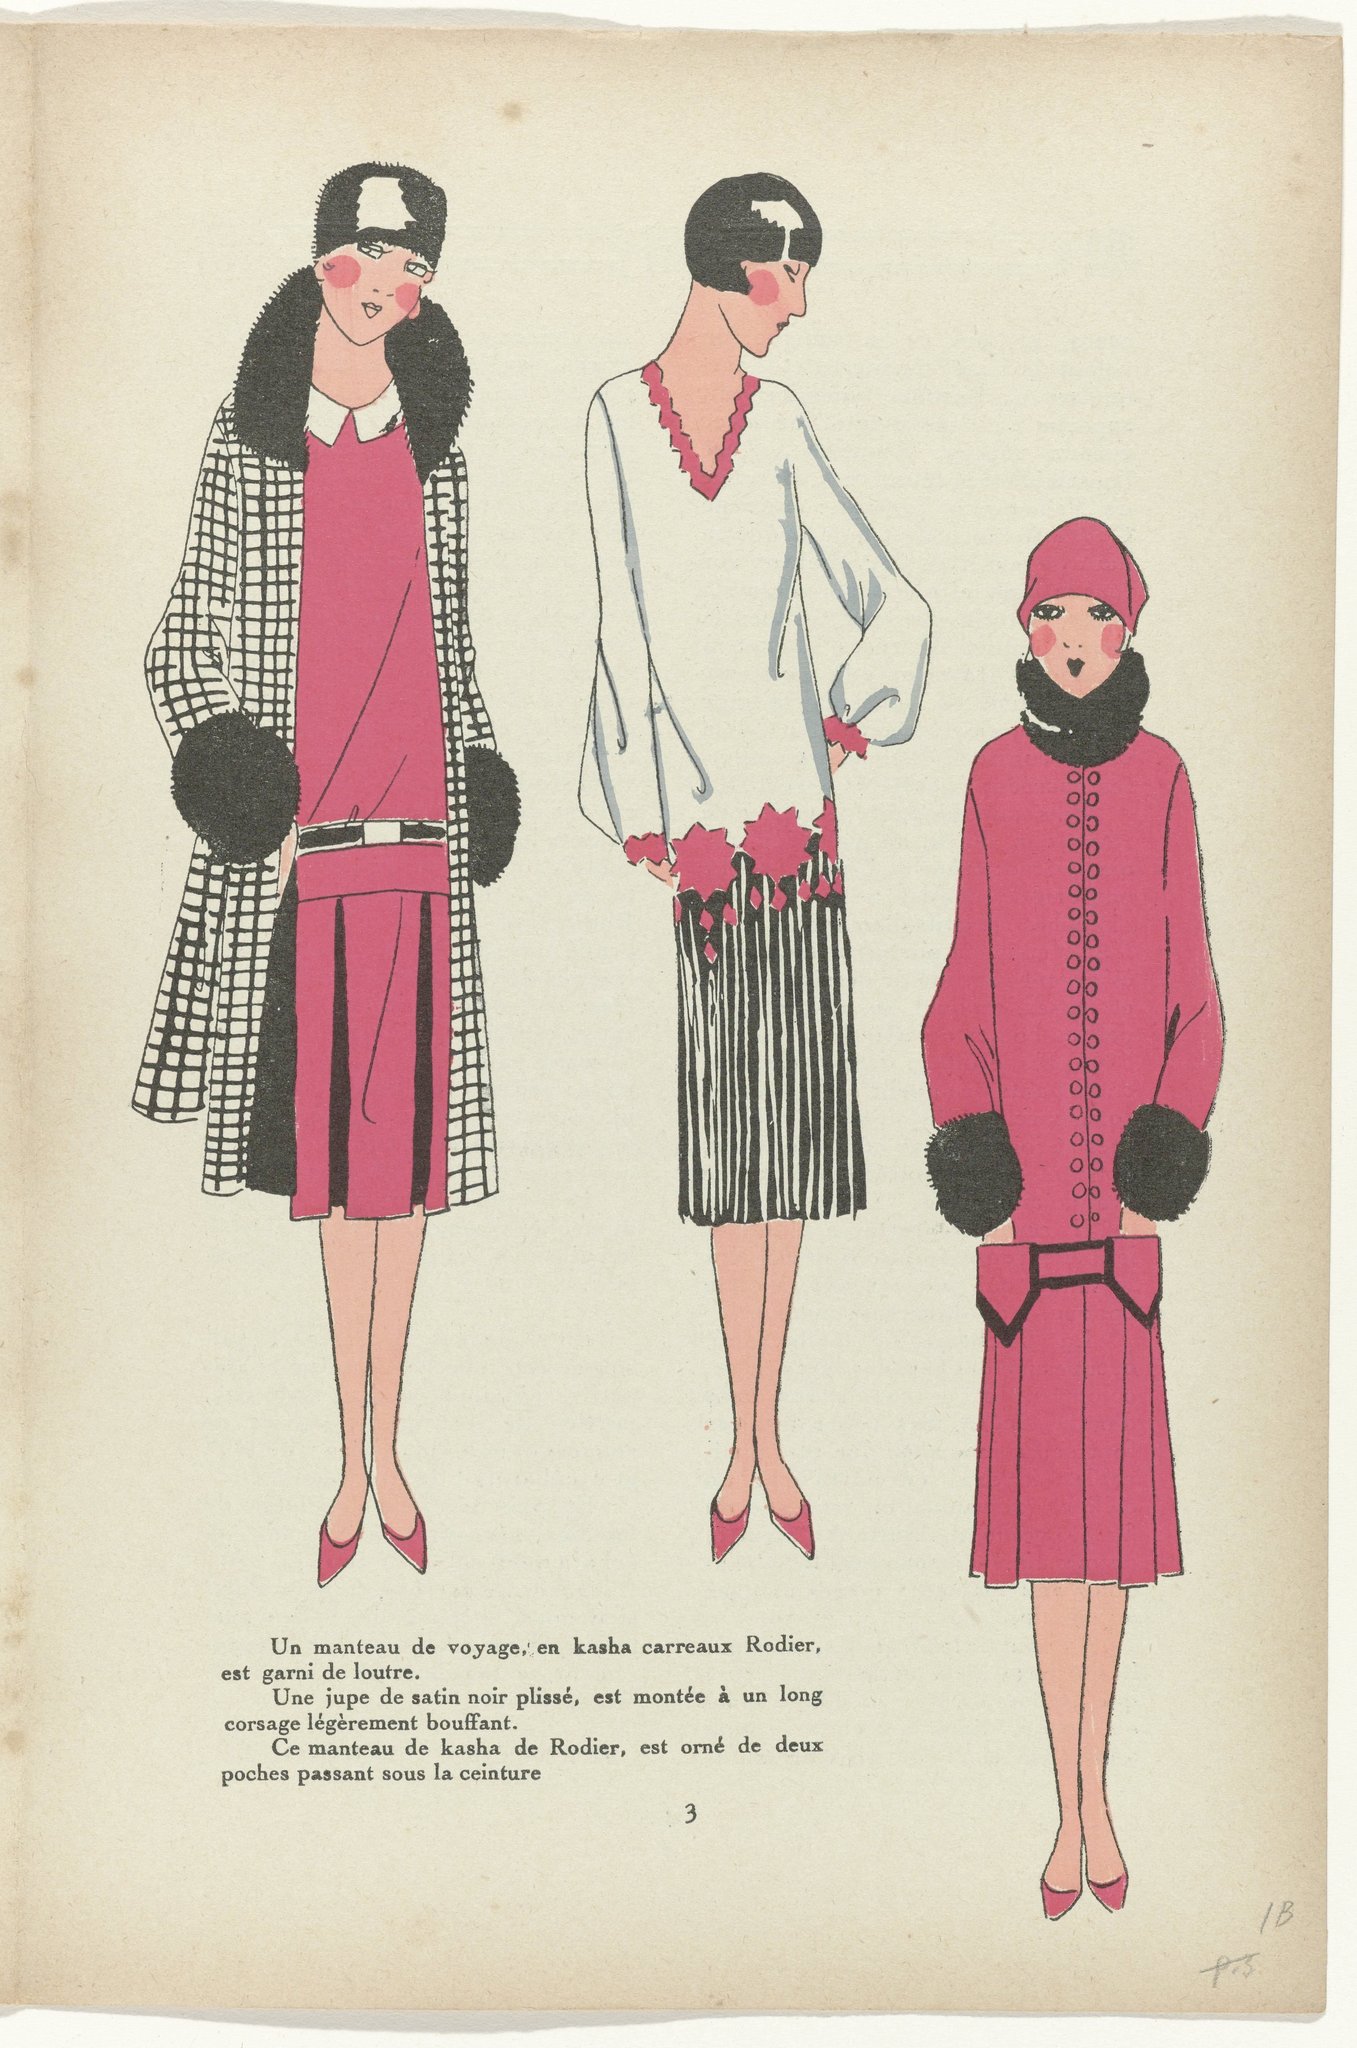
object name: fashion print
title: Très Parisien, 1925, No. 11, p. 3: Un manteau de voyag (...)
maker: g-p. joumard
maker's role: publisher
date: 1925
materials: paper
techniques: hand coloring, letterpress printing, lithography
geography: paris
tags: dress, gown: day dress (+ women's clothes), fashion plates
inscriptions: date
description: Drie creaties van Rodier. Reismantel, japon van geplisseerd satijn en mantel van kasha met vtwee zakken onder de ceintuur. Pagina 3 uit Très Parisien, No. 11, 1925